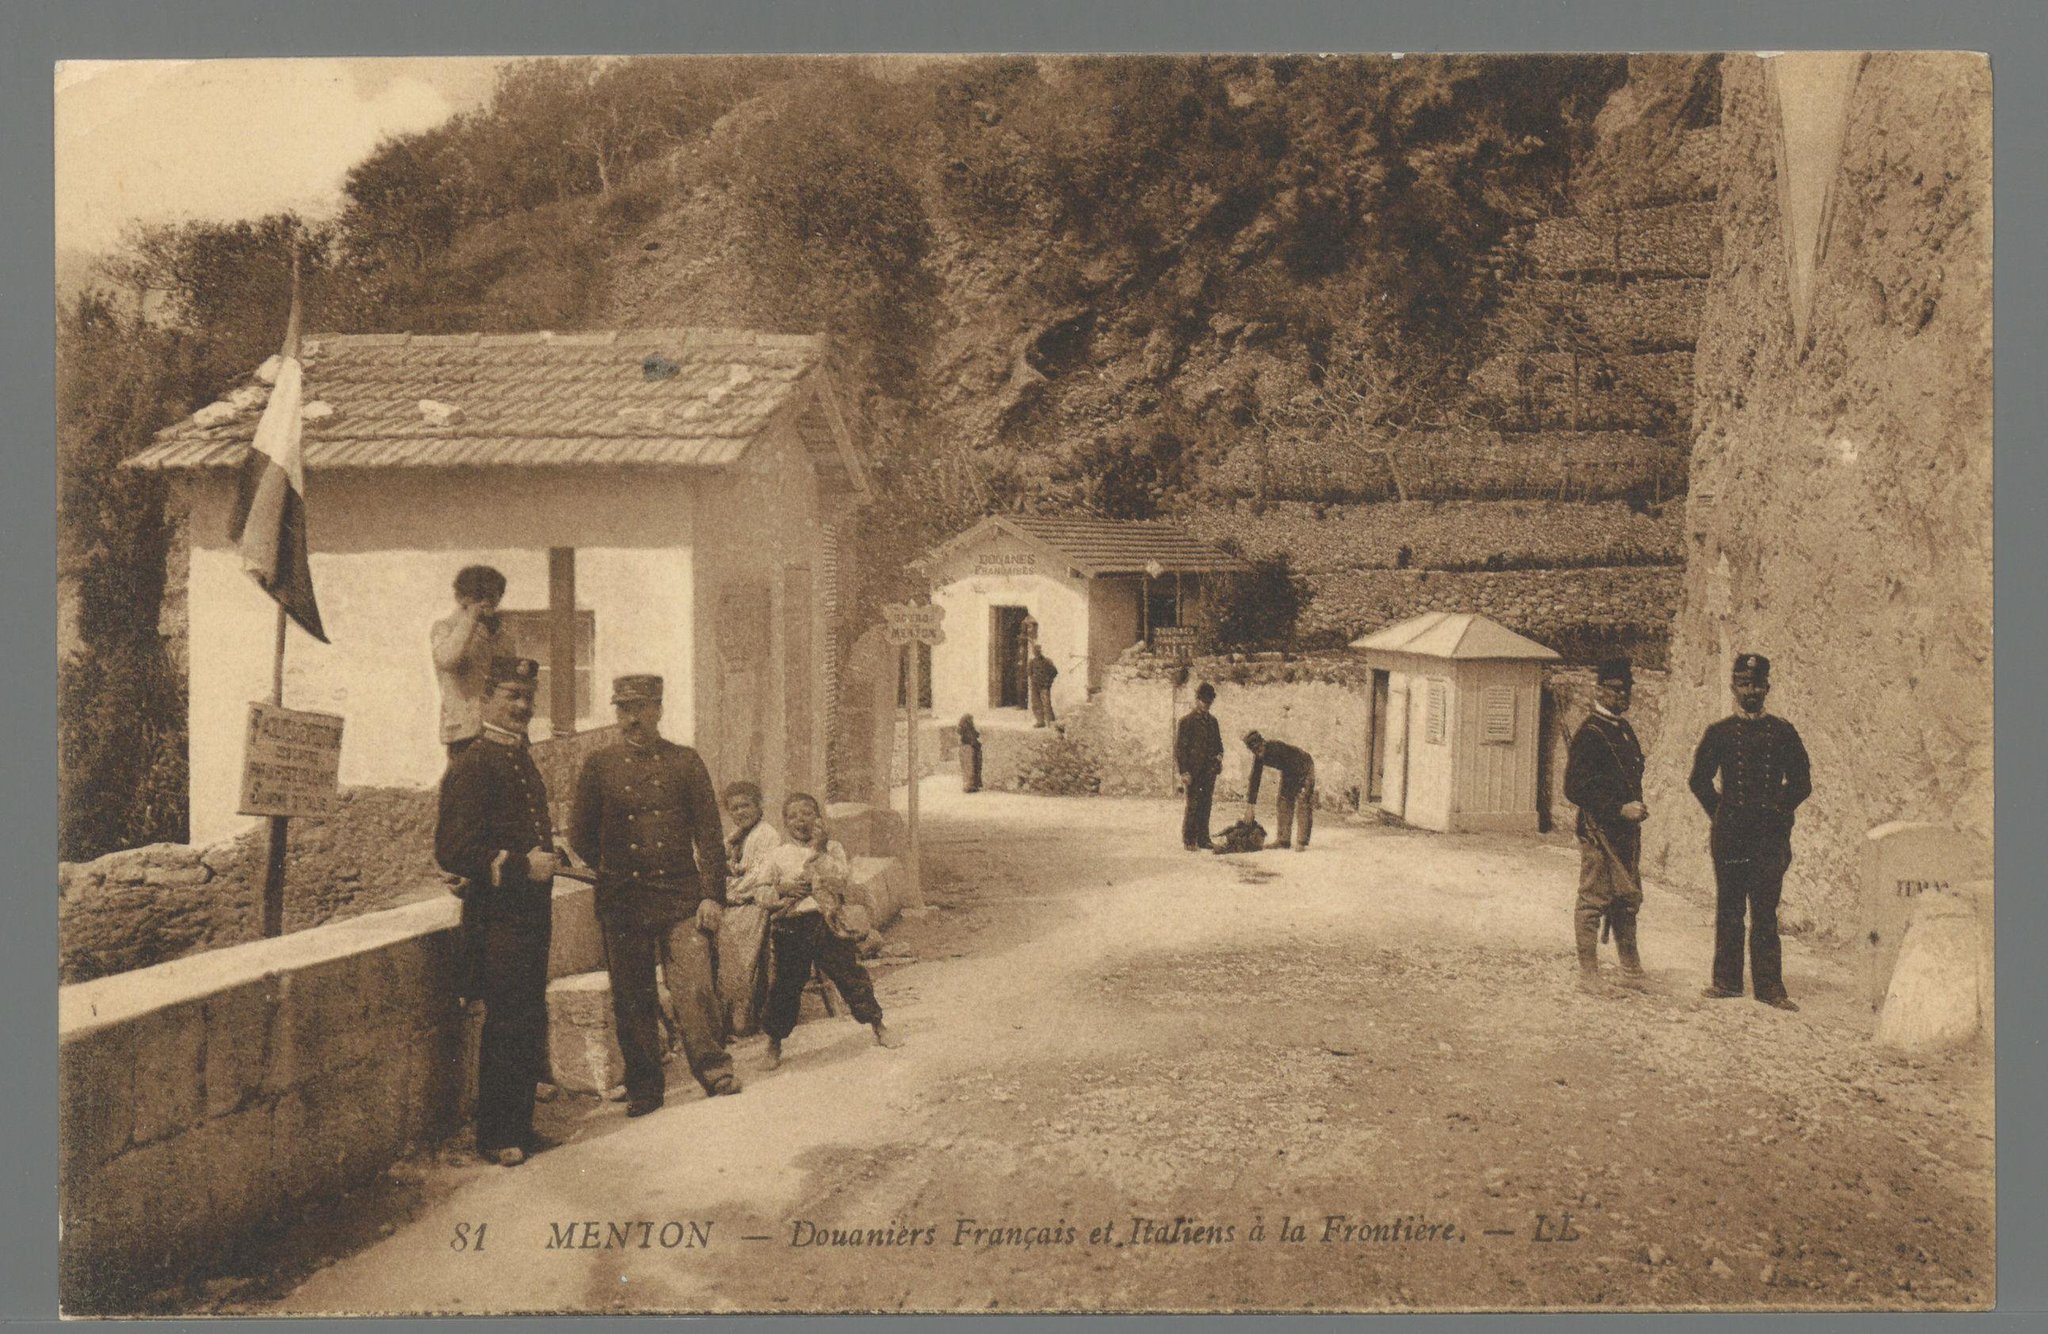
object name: photomechanical print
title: Menton. Douaniers Français et Italiens à la Frontière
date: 1904-1906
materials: cardboard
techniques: photograph, writing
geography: menton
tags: frontiers, boundaries, mountains (+ landscape with figures, staffage), flag, colours (as symbol of the state, etc.)